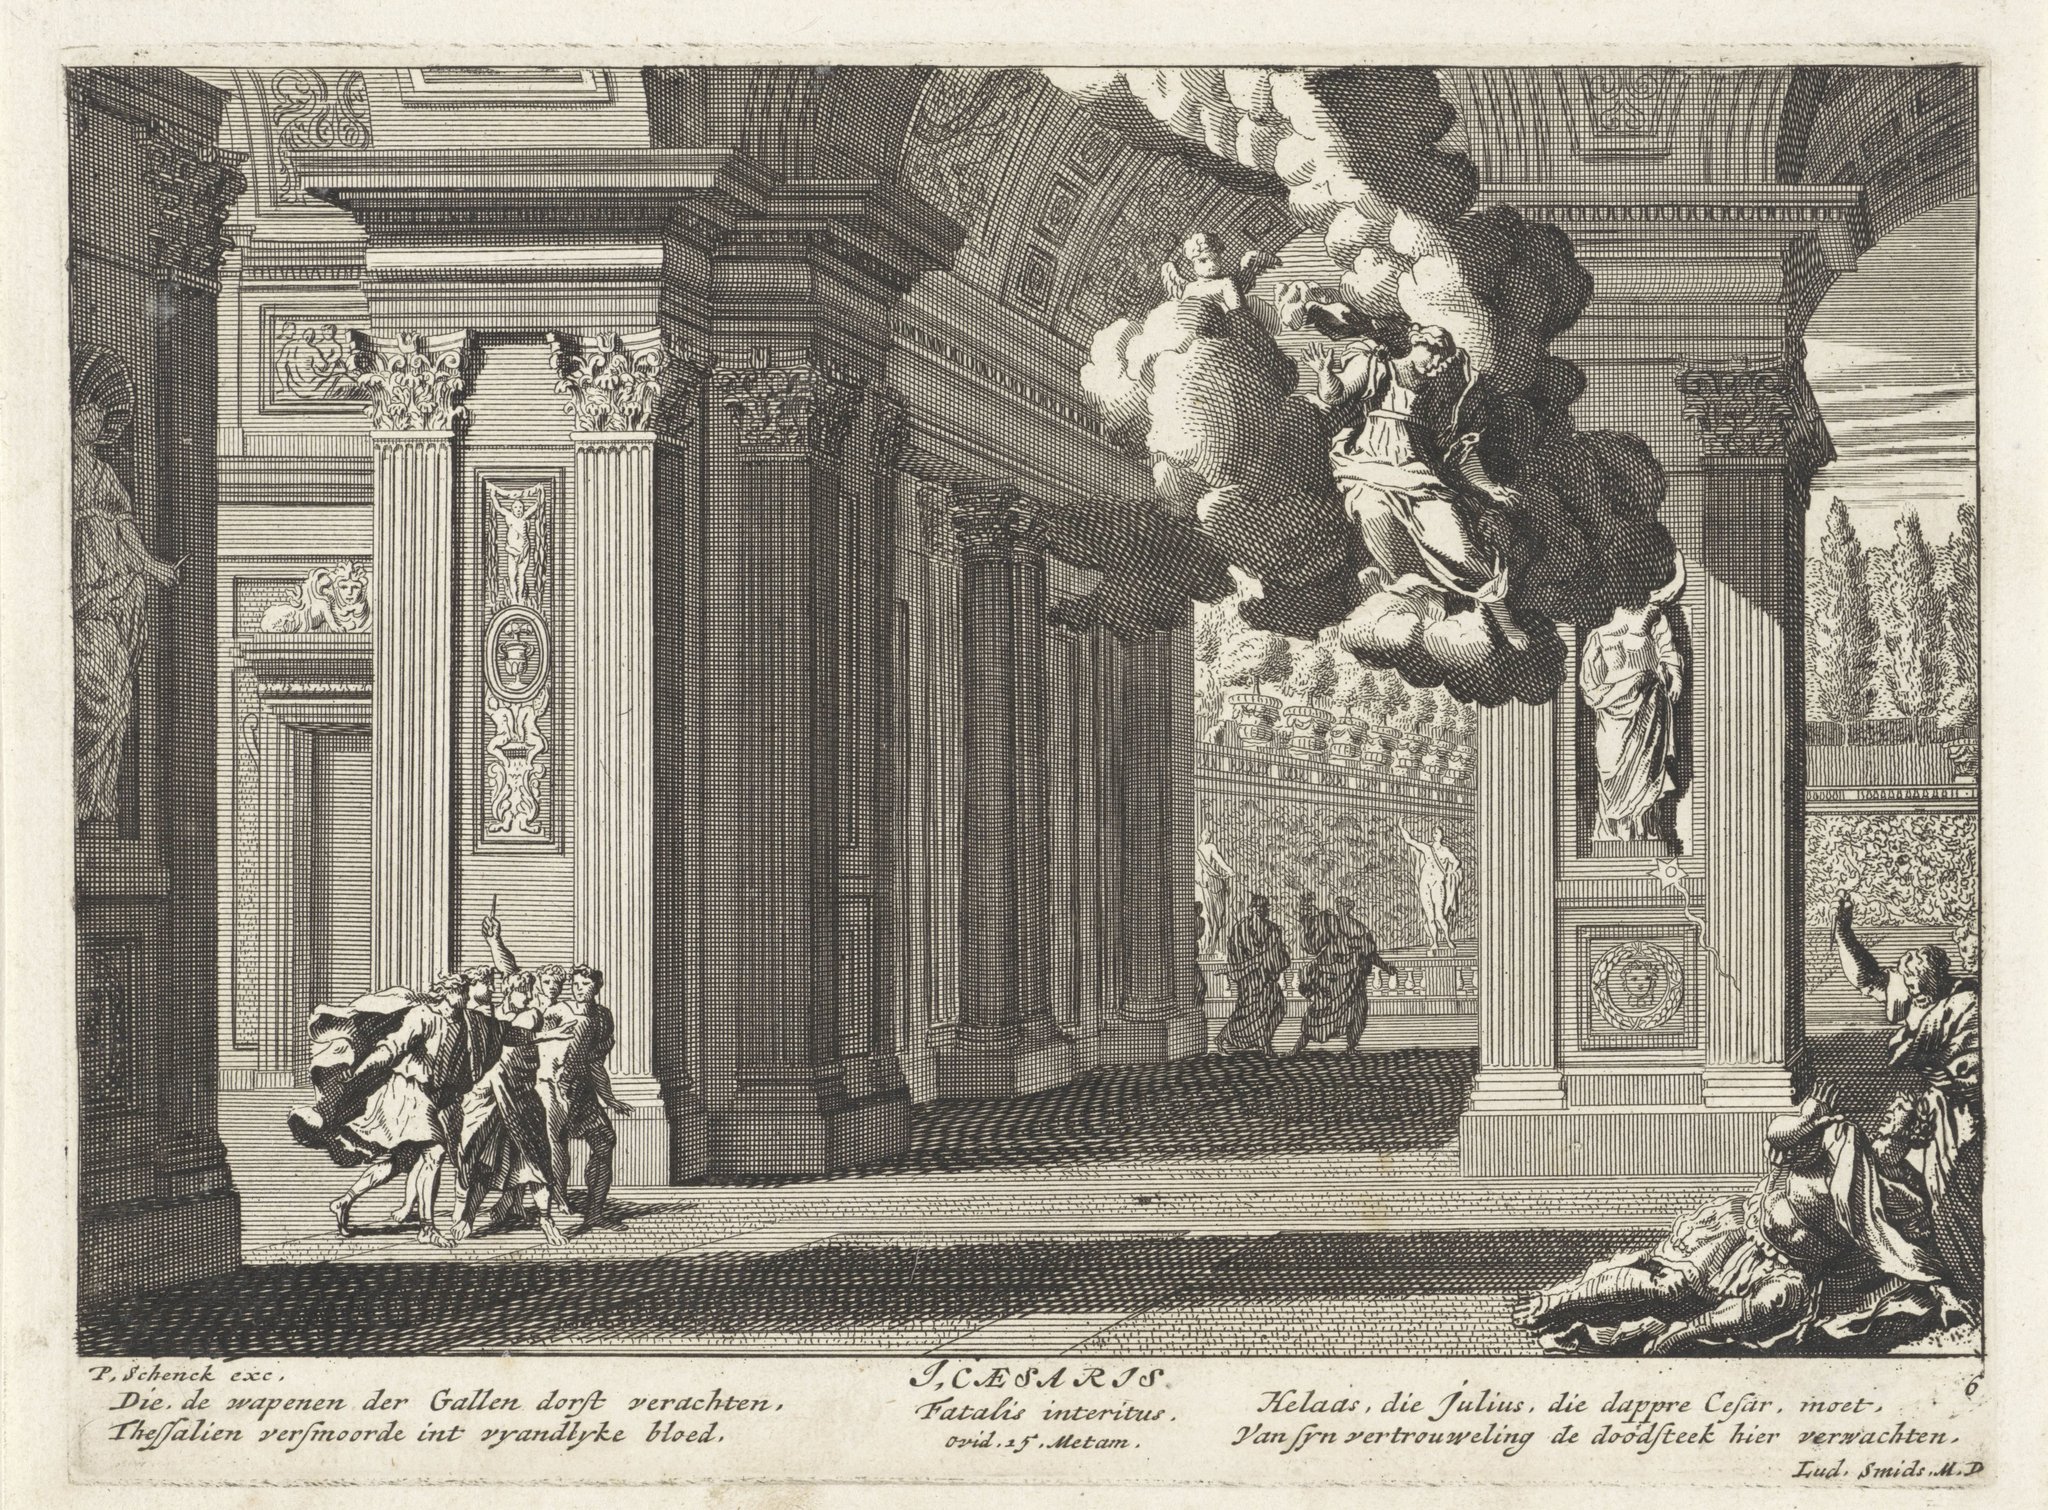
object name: print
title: Dood van Julius Caesar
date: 1675-1711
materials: paper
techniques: engraving, etching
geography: amsterdam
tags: death of caesar, i.e. the murder of caesar: he is slain in the senate at the foot of pompey's statue, exclaiming 'et tu brute'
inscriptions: collector's mark: Lugt 2166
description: De dood van Julius Caesar. In de senaat wordt hij doodgestoken. Een godin verschijnt in een wolk. Onder de voorstelling een vierregelig vers in het Nederlands en een verwijzing naar een tekst in de Metamorfosen van Ovidius.